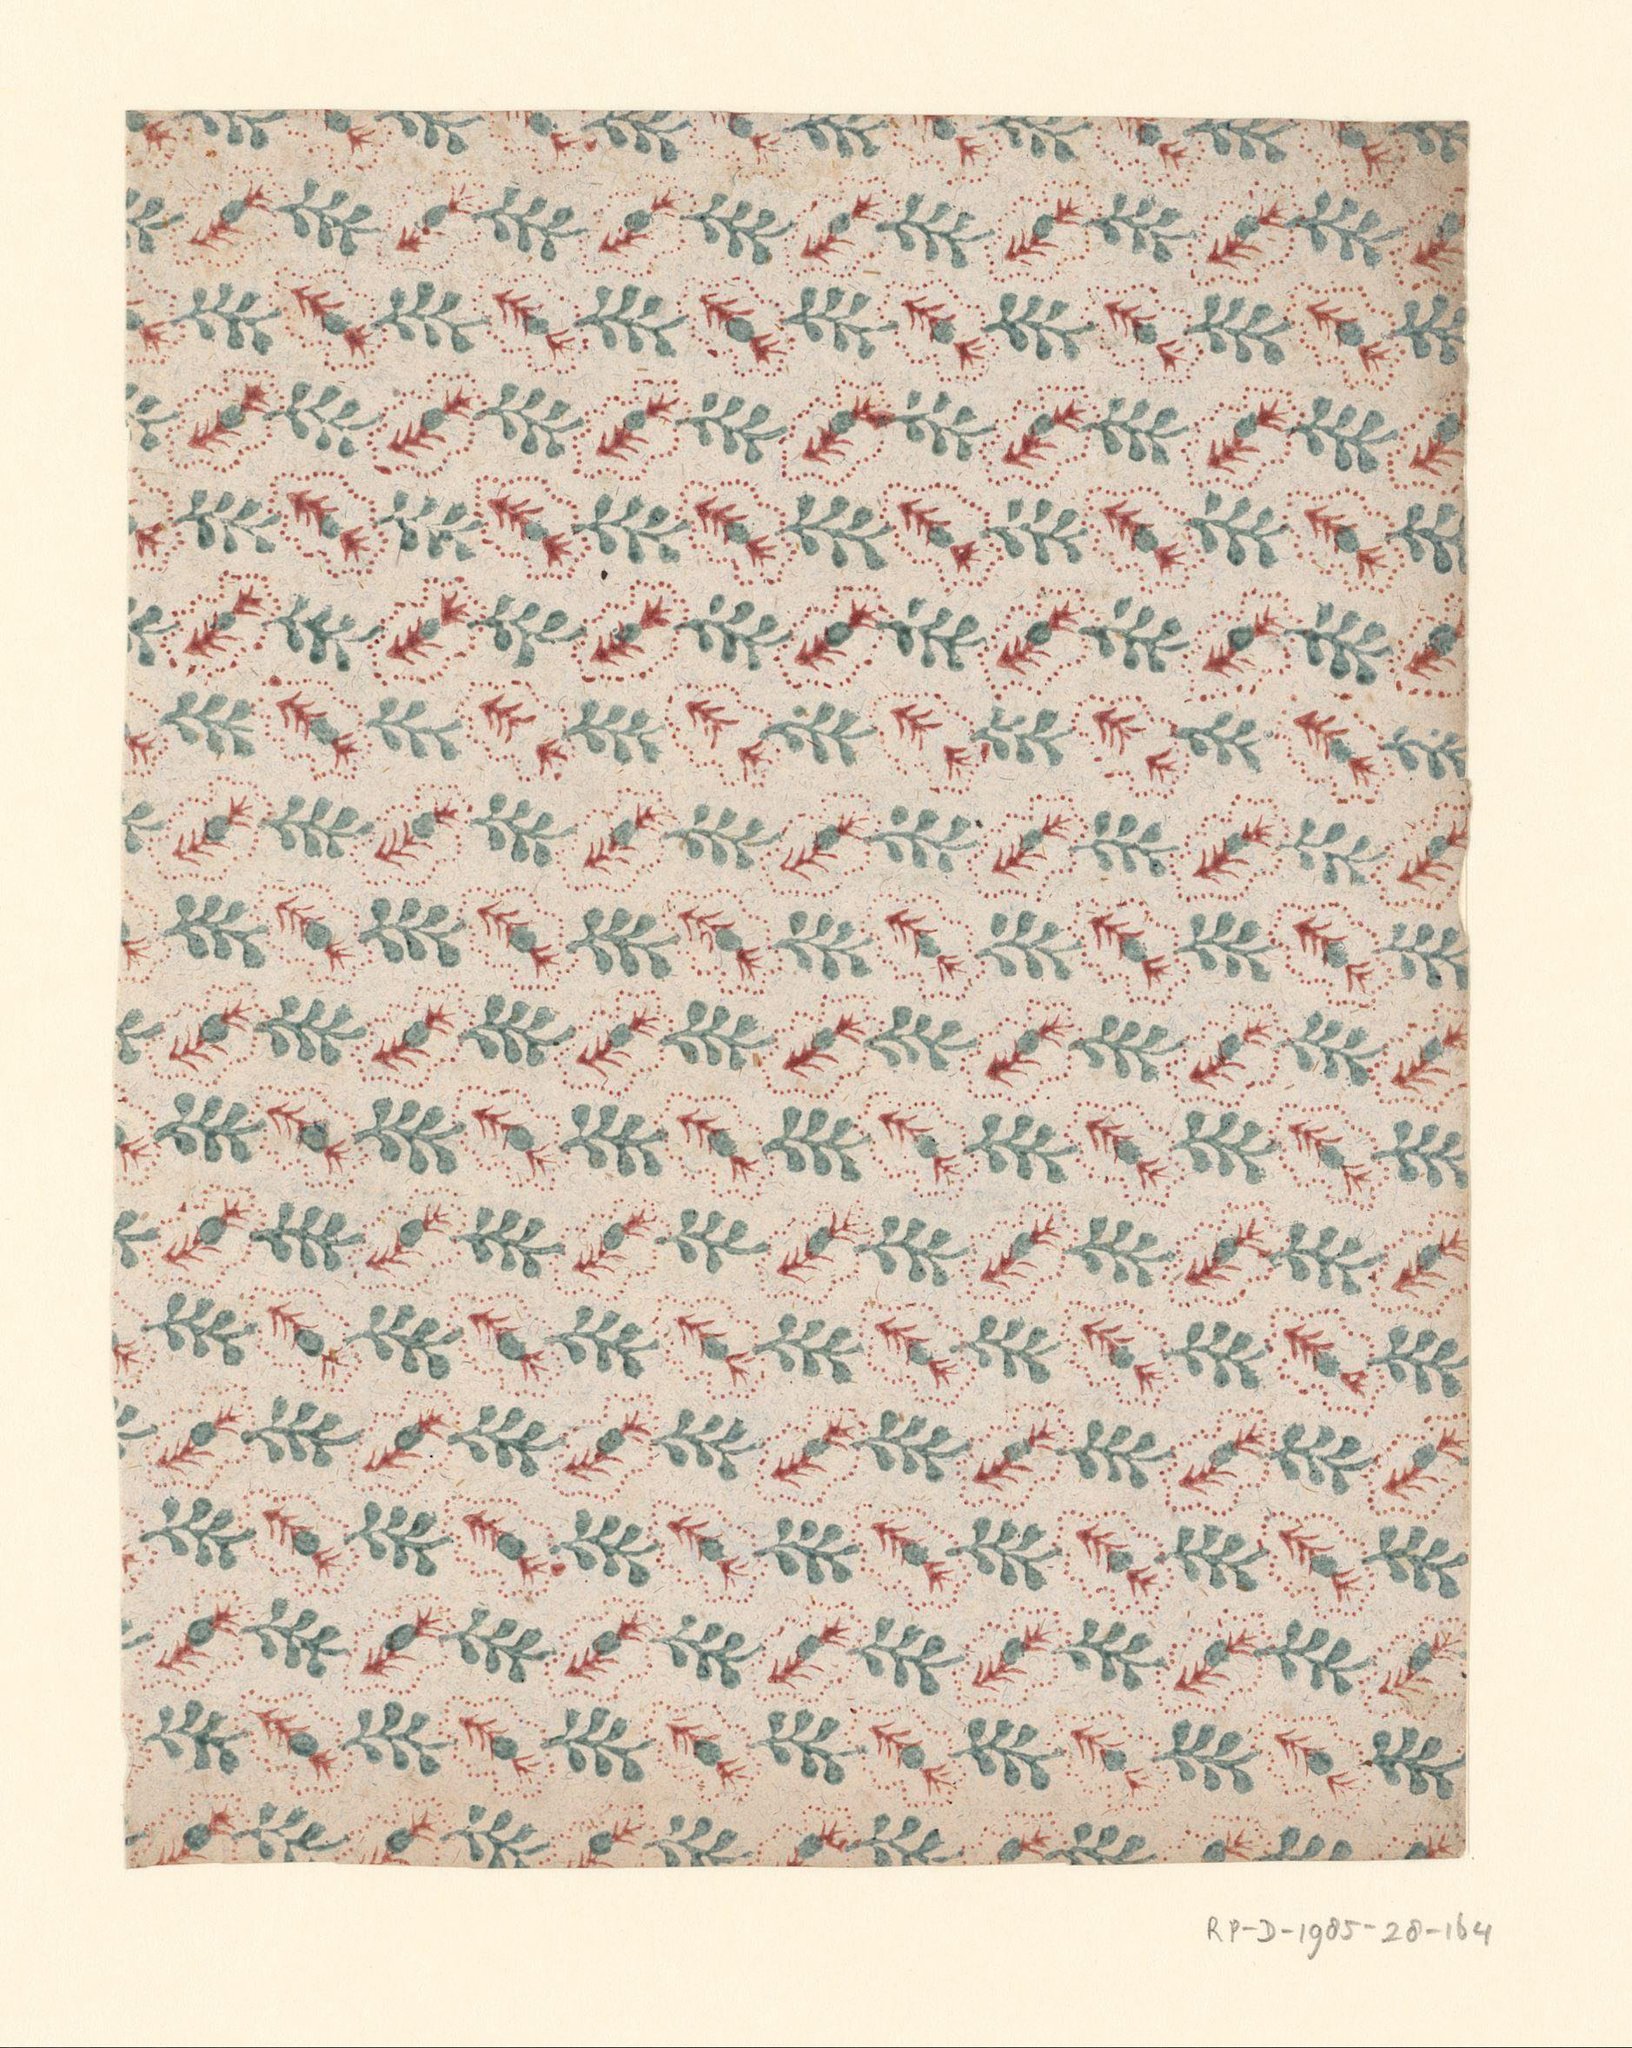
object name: printed paper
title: Blad met golvend banenpatroon van takjes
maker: Anonymous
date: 1750-1900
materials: paper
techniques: printing block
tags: ornament derived from plant forms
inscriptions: collector's mark: Lugt 2760, collector's mark: Lugt 2228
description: Blad met golvend banenpatroon van takjes. Helft van een omslag.